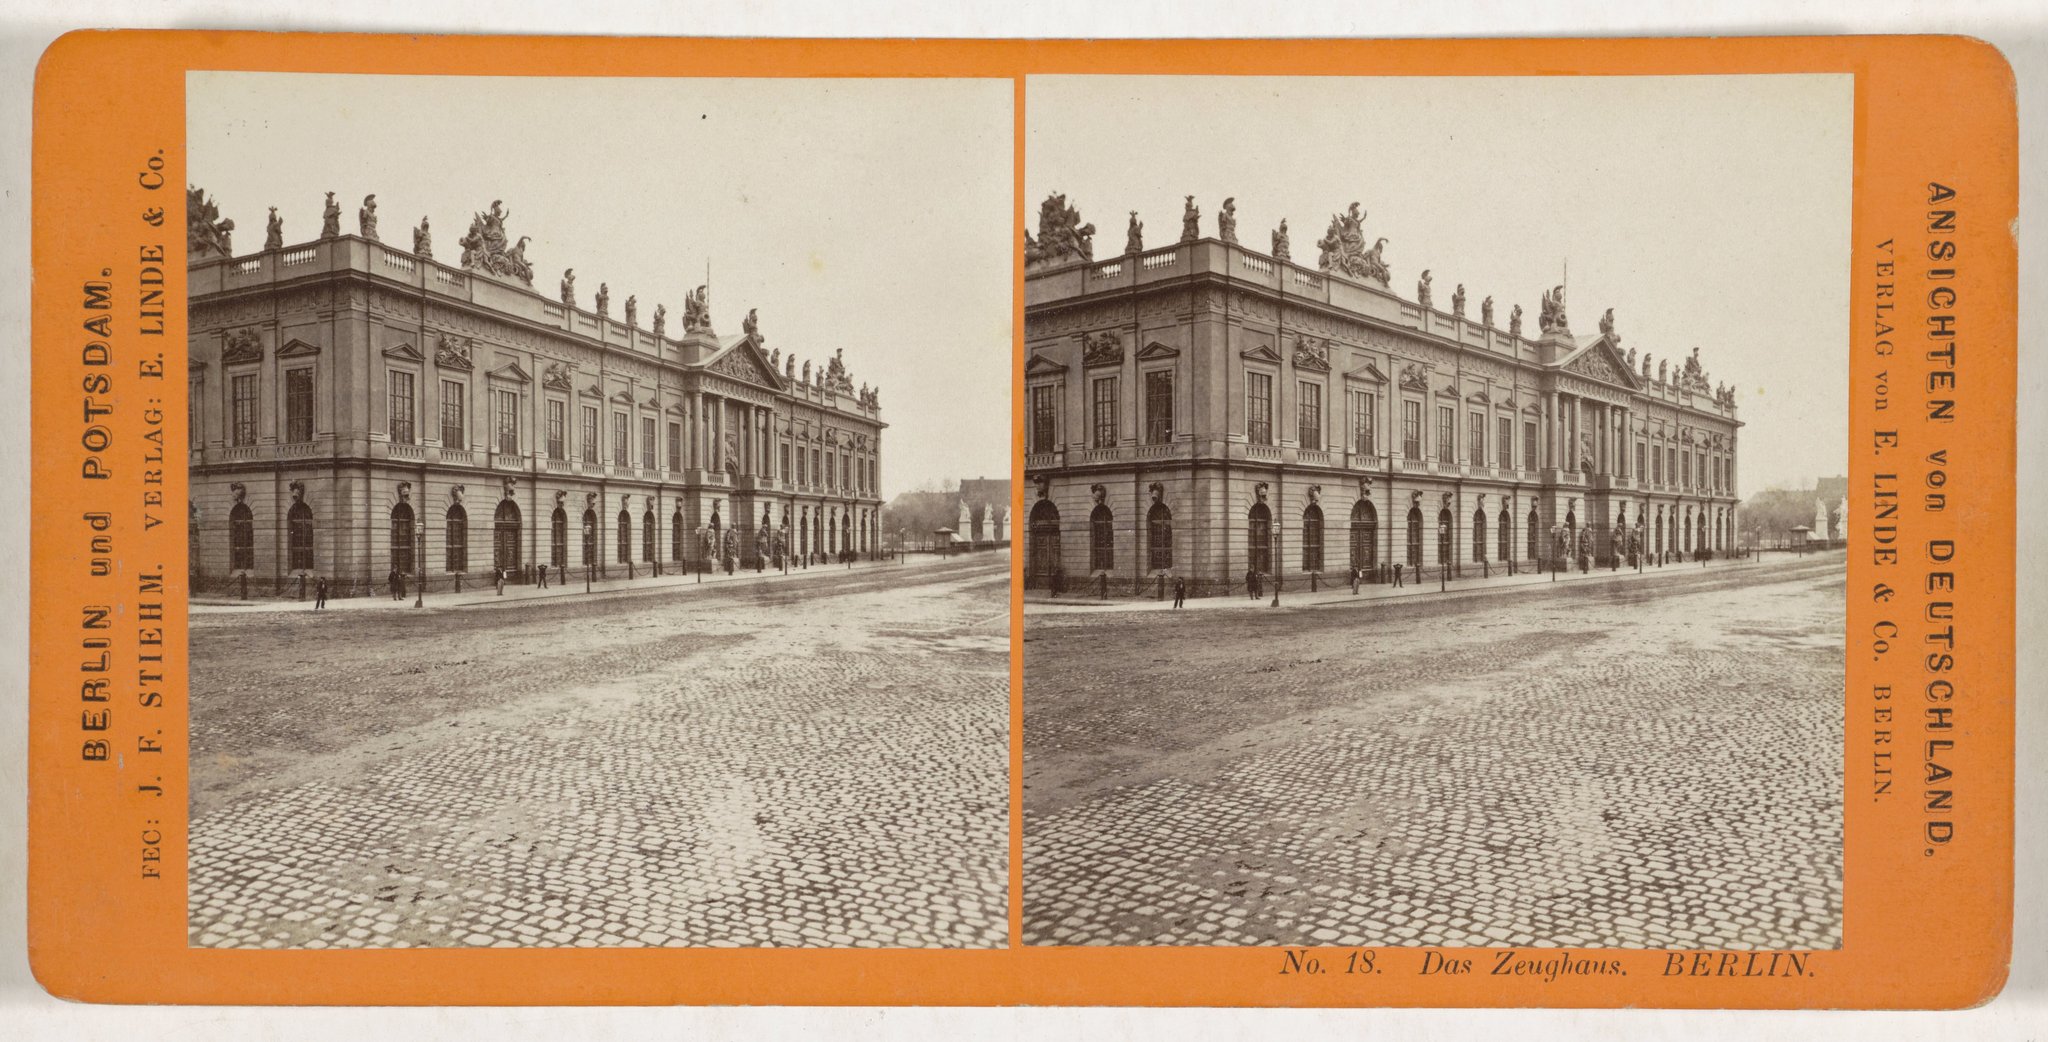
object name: stereograph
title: Zeughaus in Berlijn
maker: johann friedrich stiehm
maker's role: fotograaf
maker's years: 1826-1902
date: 1868-1870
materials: cardboard, paper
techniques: albumen print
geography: berlin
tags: ammunition store, arsenal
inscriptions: number: ‘No. 18.’